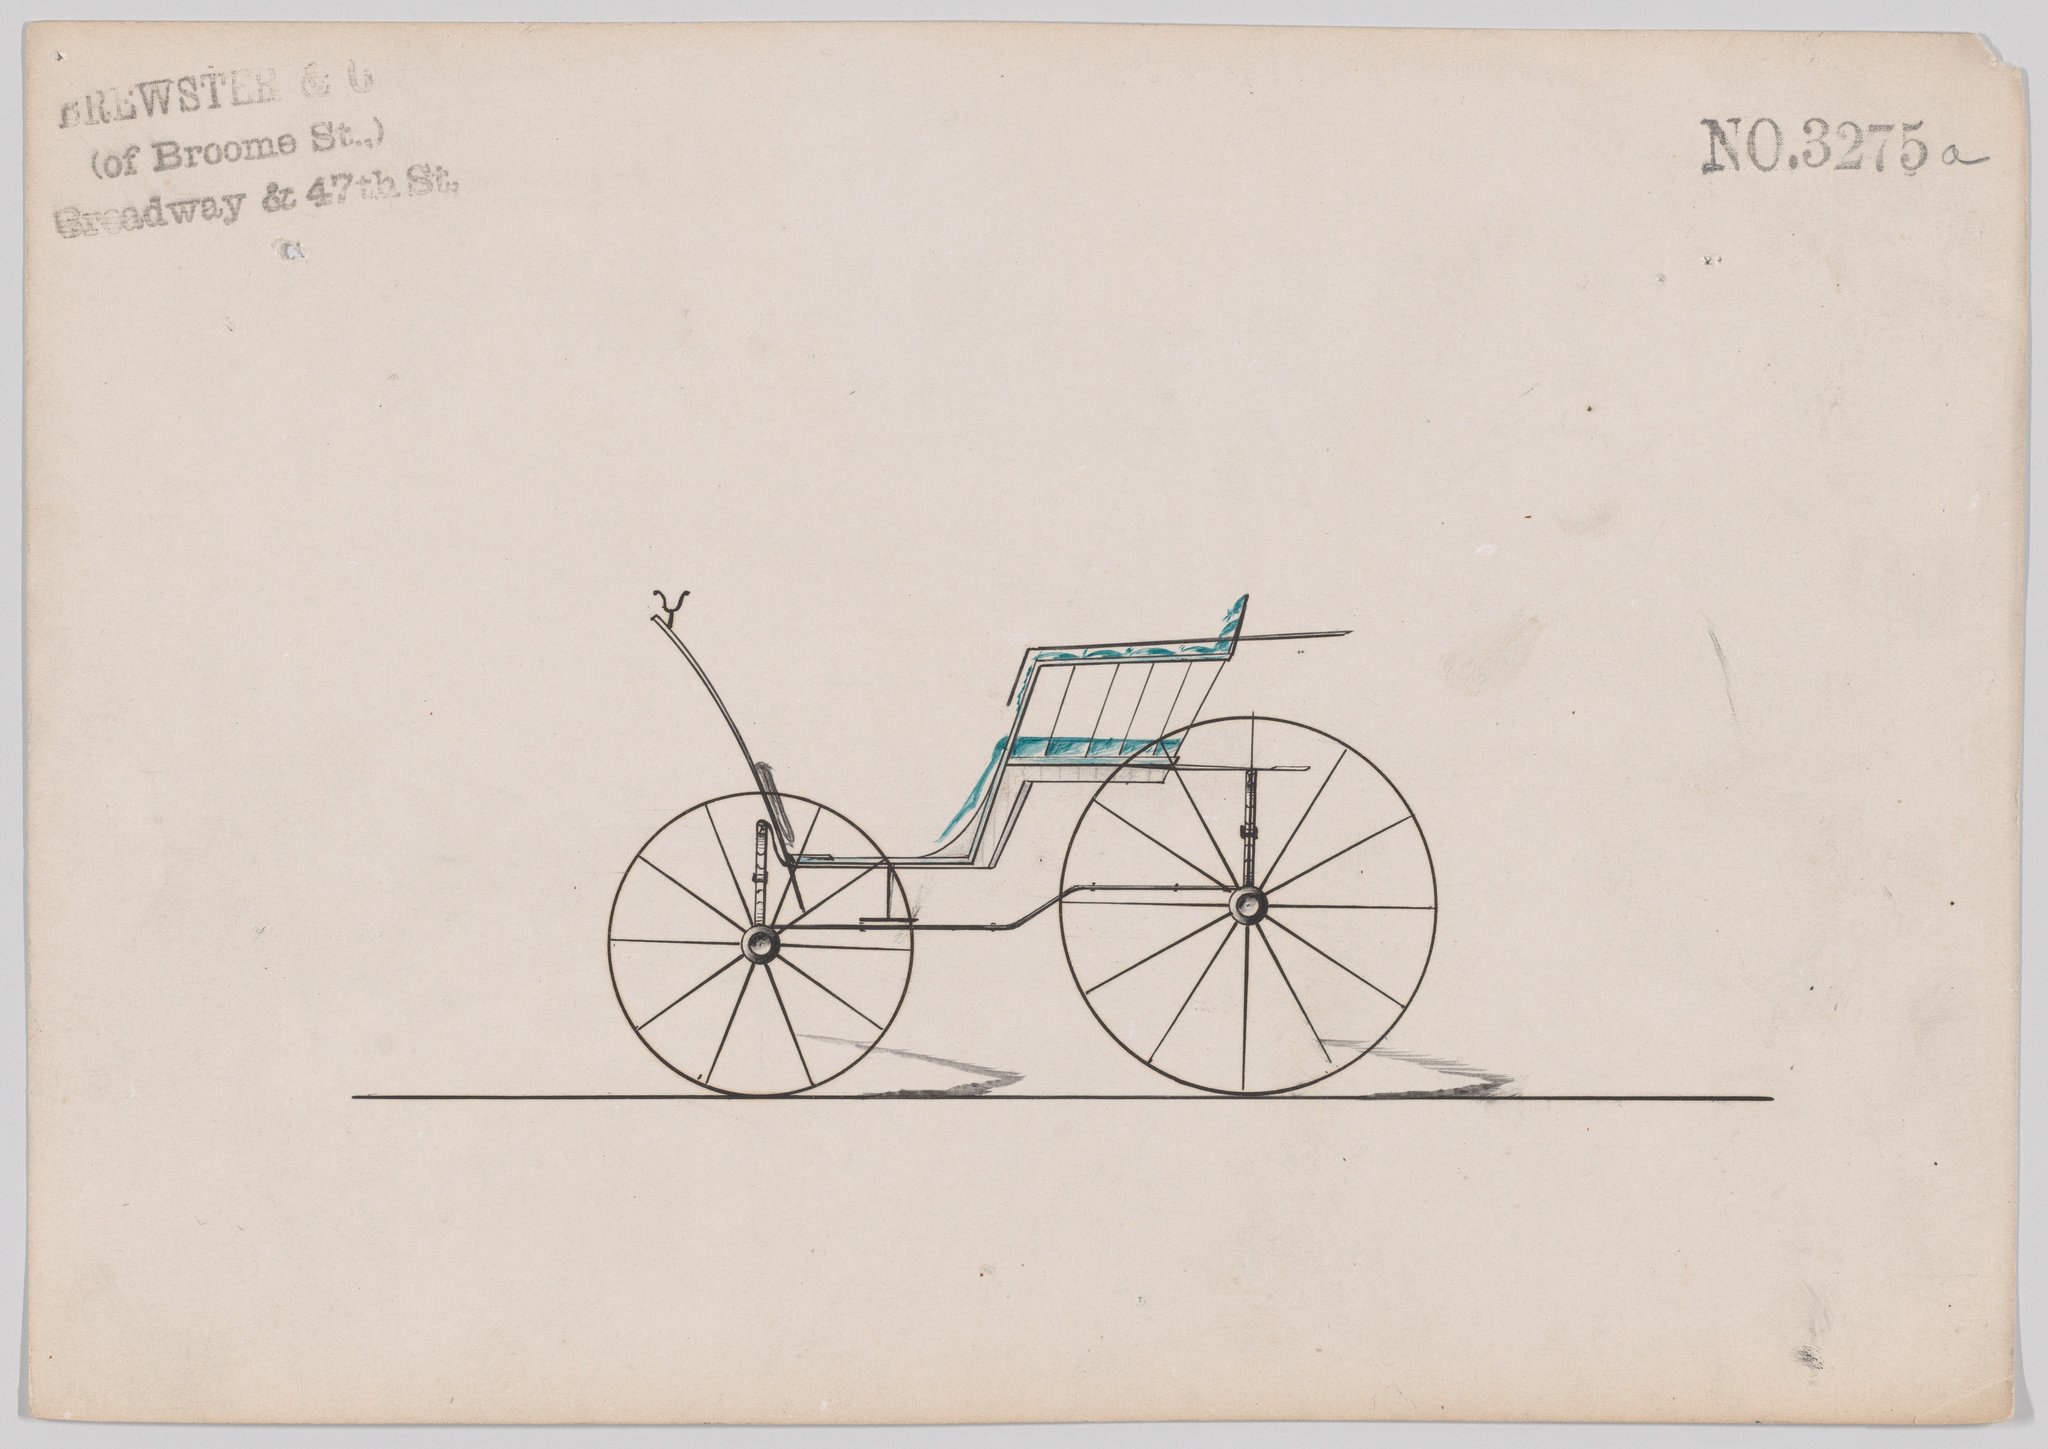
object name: drawing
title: Design for Pony Phaeton, no. 3275a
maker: brewster & co.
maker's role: manufacturer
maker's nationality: american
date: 1876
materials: gouache, ink, watercolor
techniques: pen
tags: carriages